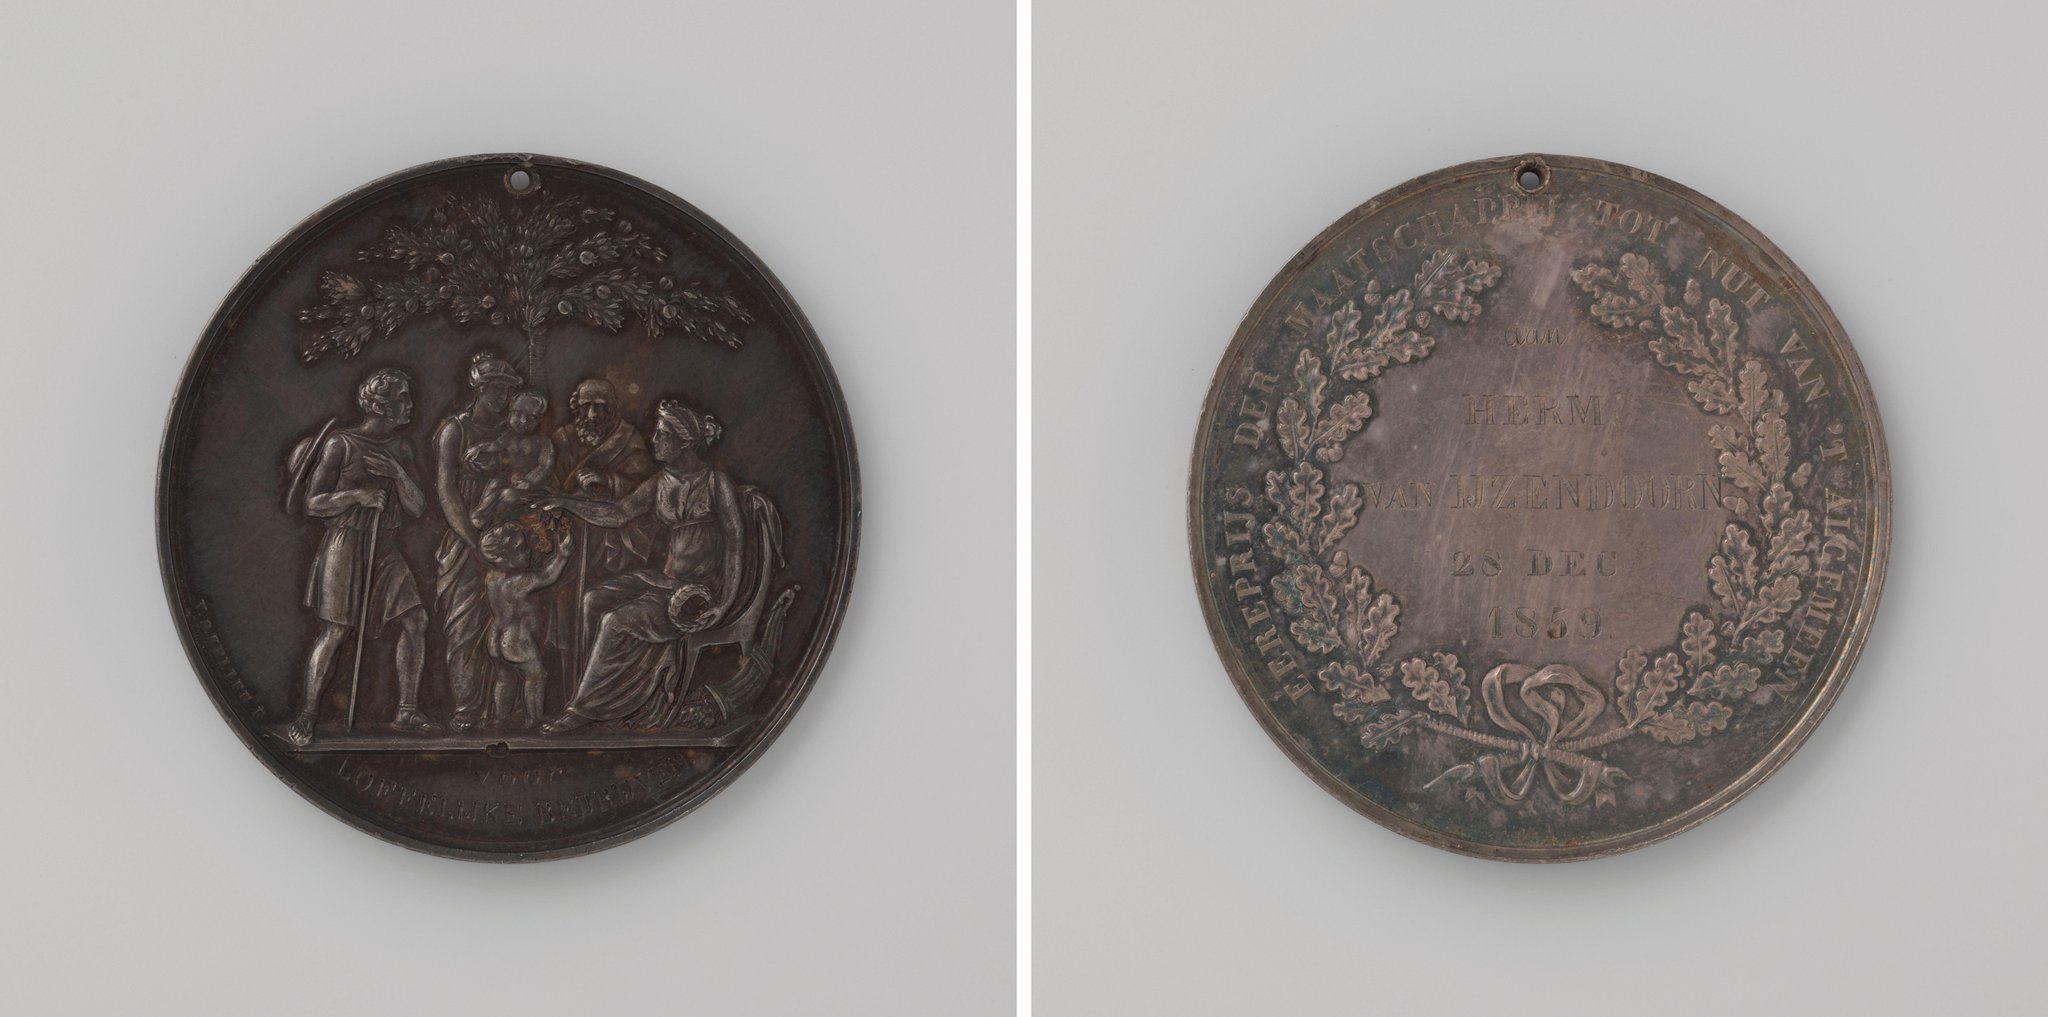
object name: medal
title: Maatschappij tot Nut van 't Algemeen, penning uitgereikt aan Herm. van IJzendoorn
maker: david van der kellen (1804-1879)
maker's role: die cutter, draughtsman, print maker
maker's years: 1804-1879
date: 1859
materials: silver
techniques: engraving, striking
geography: utrecht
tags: herm. van ijzendoorn, maatschappij tot nut van 't algemeen